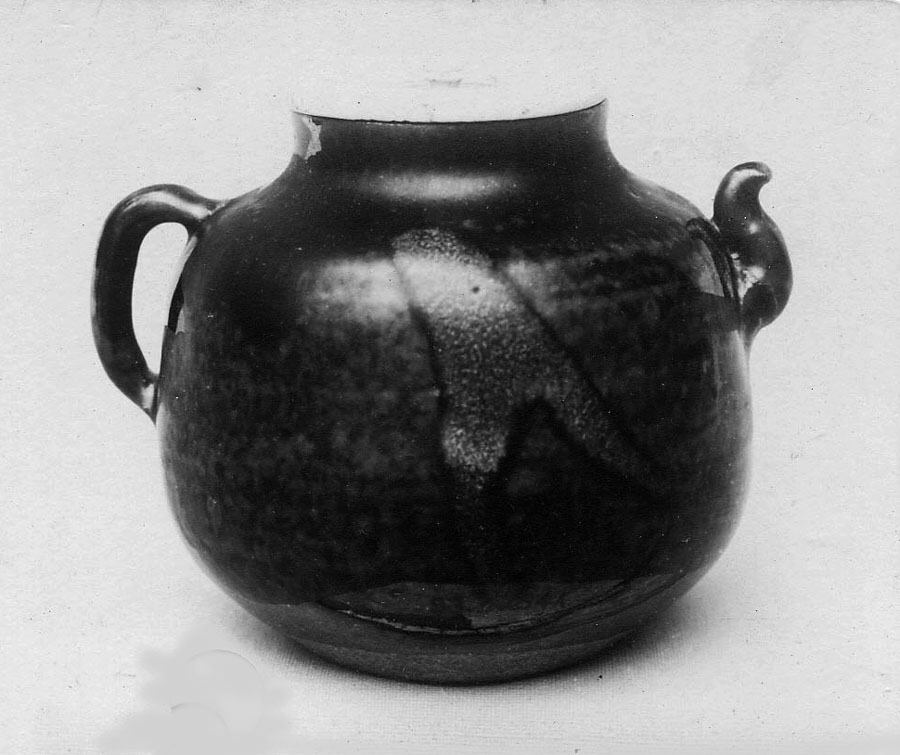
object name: tea jar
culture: japanese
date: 1820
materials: clay, glaze